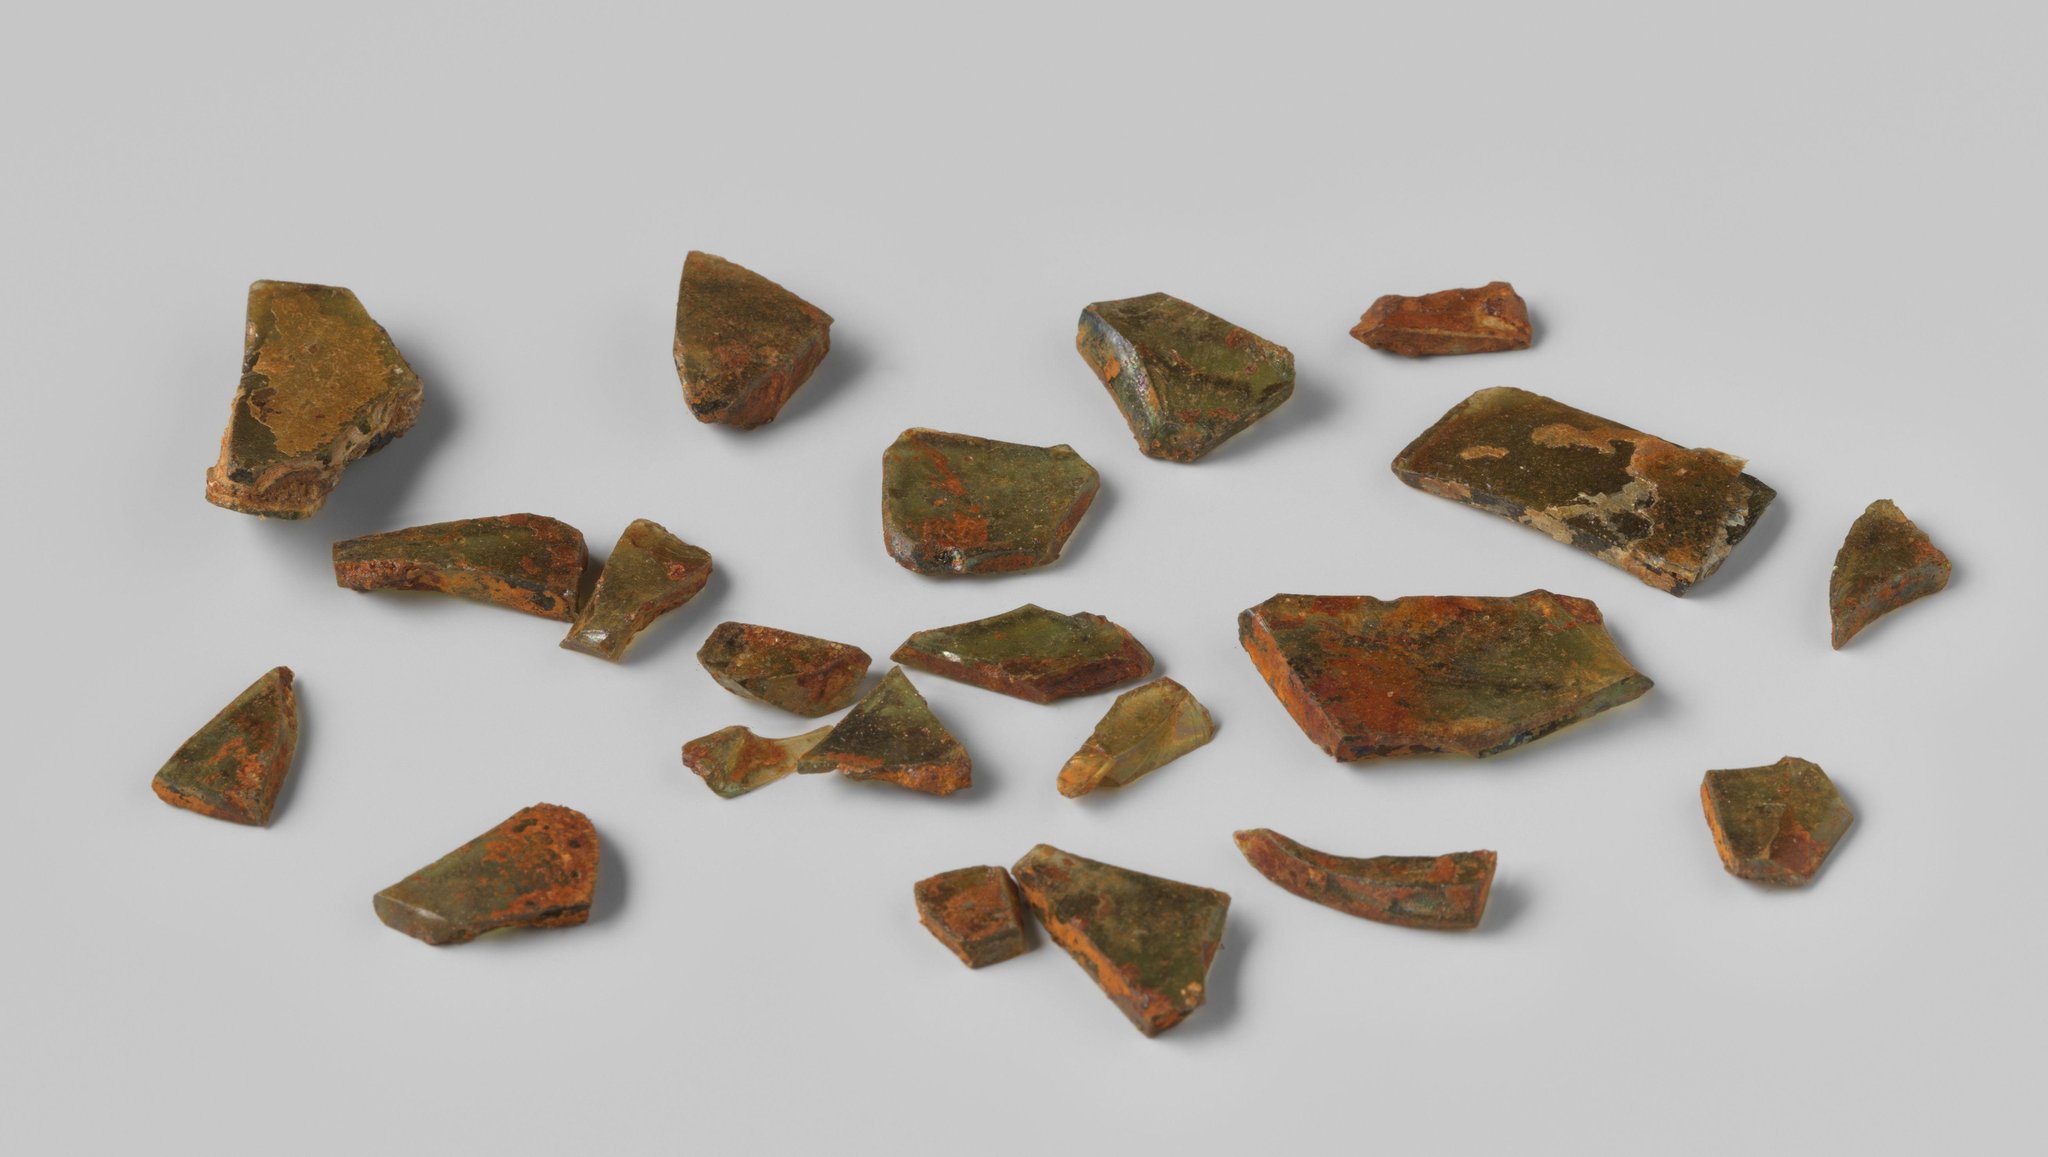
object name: bottle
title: Scherven van flessen uit het wrak van de Oostindiëvaarder Hollandia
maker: Anonymous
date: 1700-1743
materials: glass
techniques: green glass